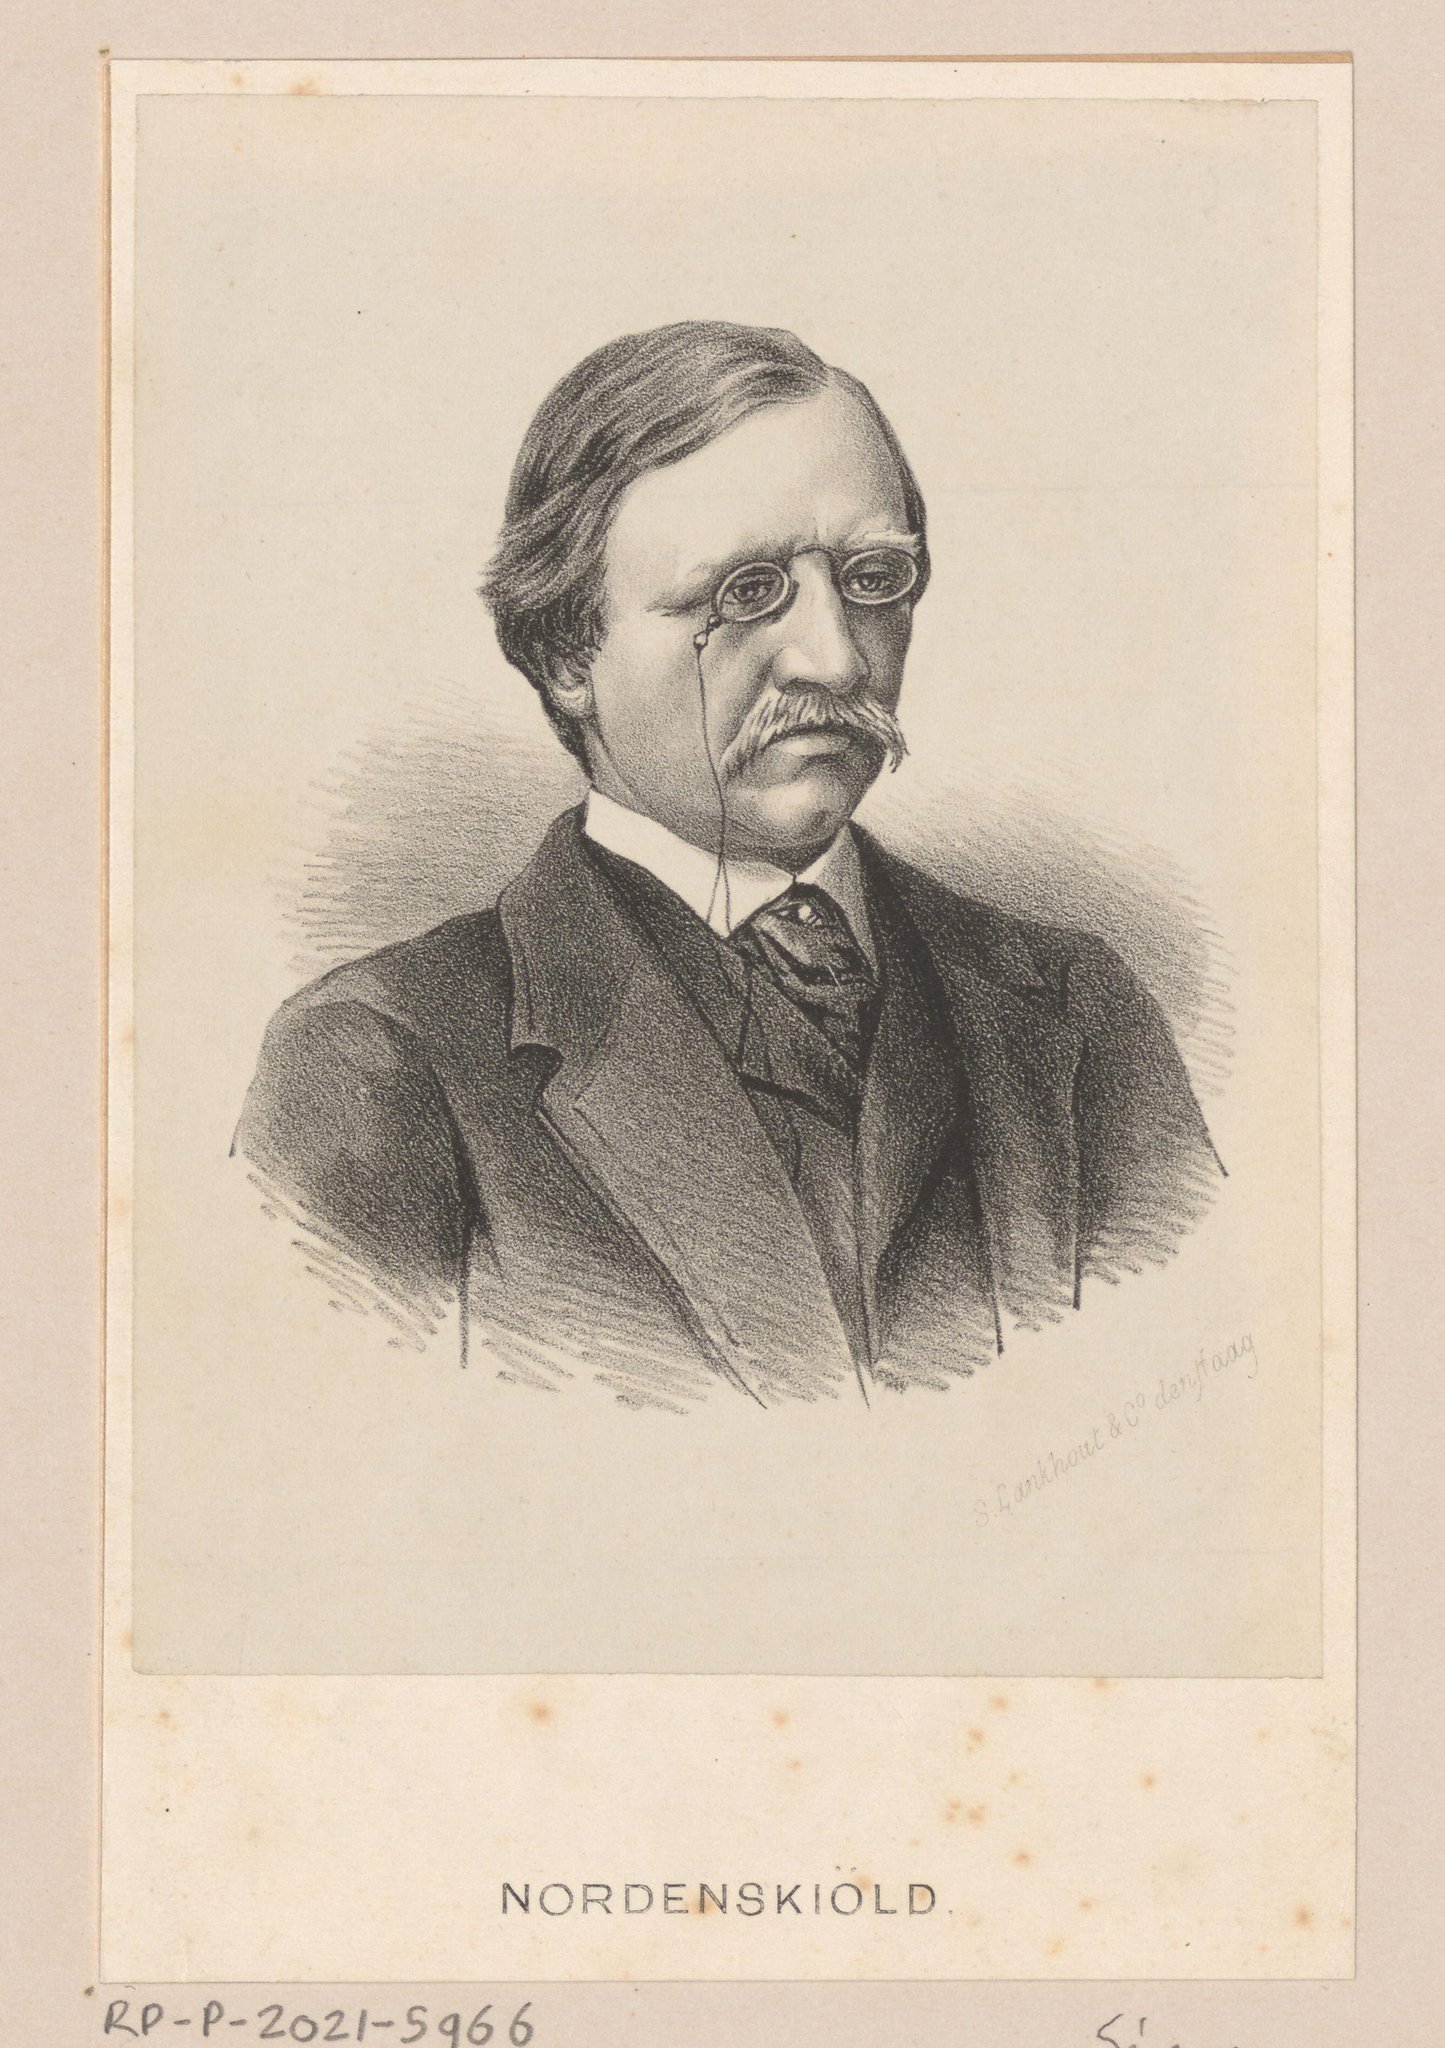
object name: print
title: Portret van Adolf Erik Nordenskiöld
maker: Anonymous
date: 1877-1903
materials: paper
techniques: lithograph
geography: the hague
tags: historical persons, explorer